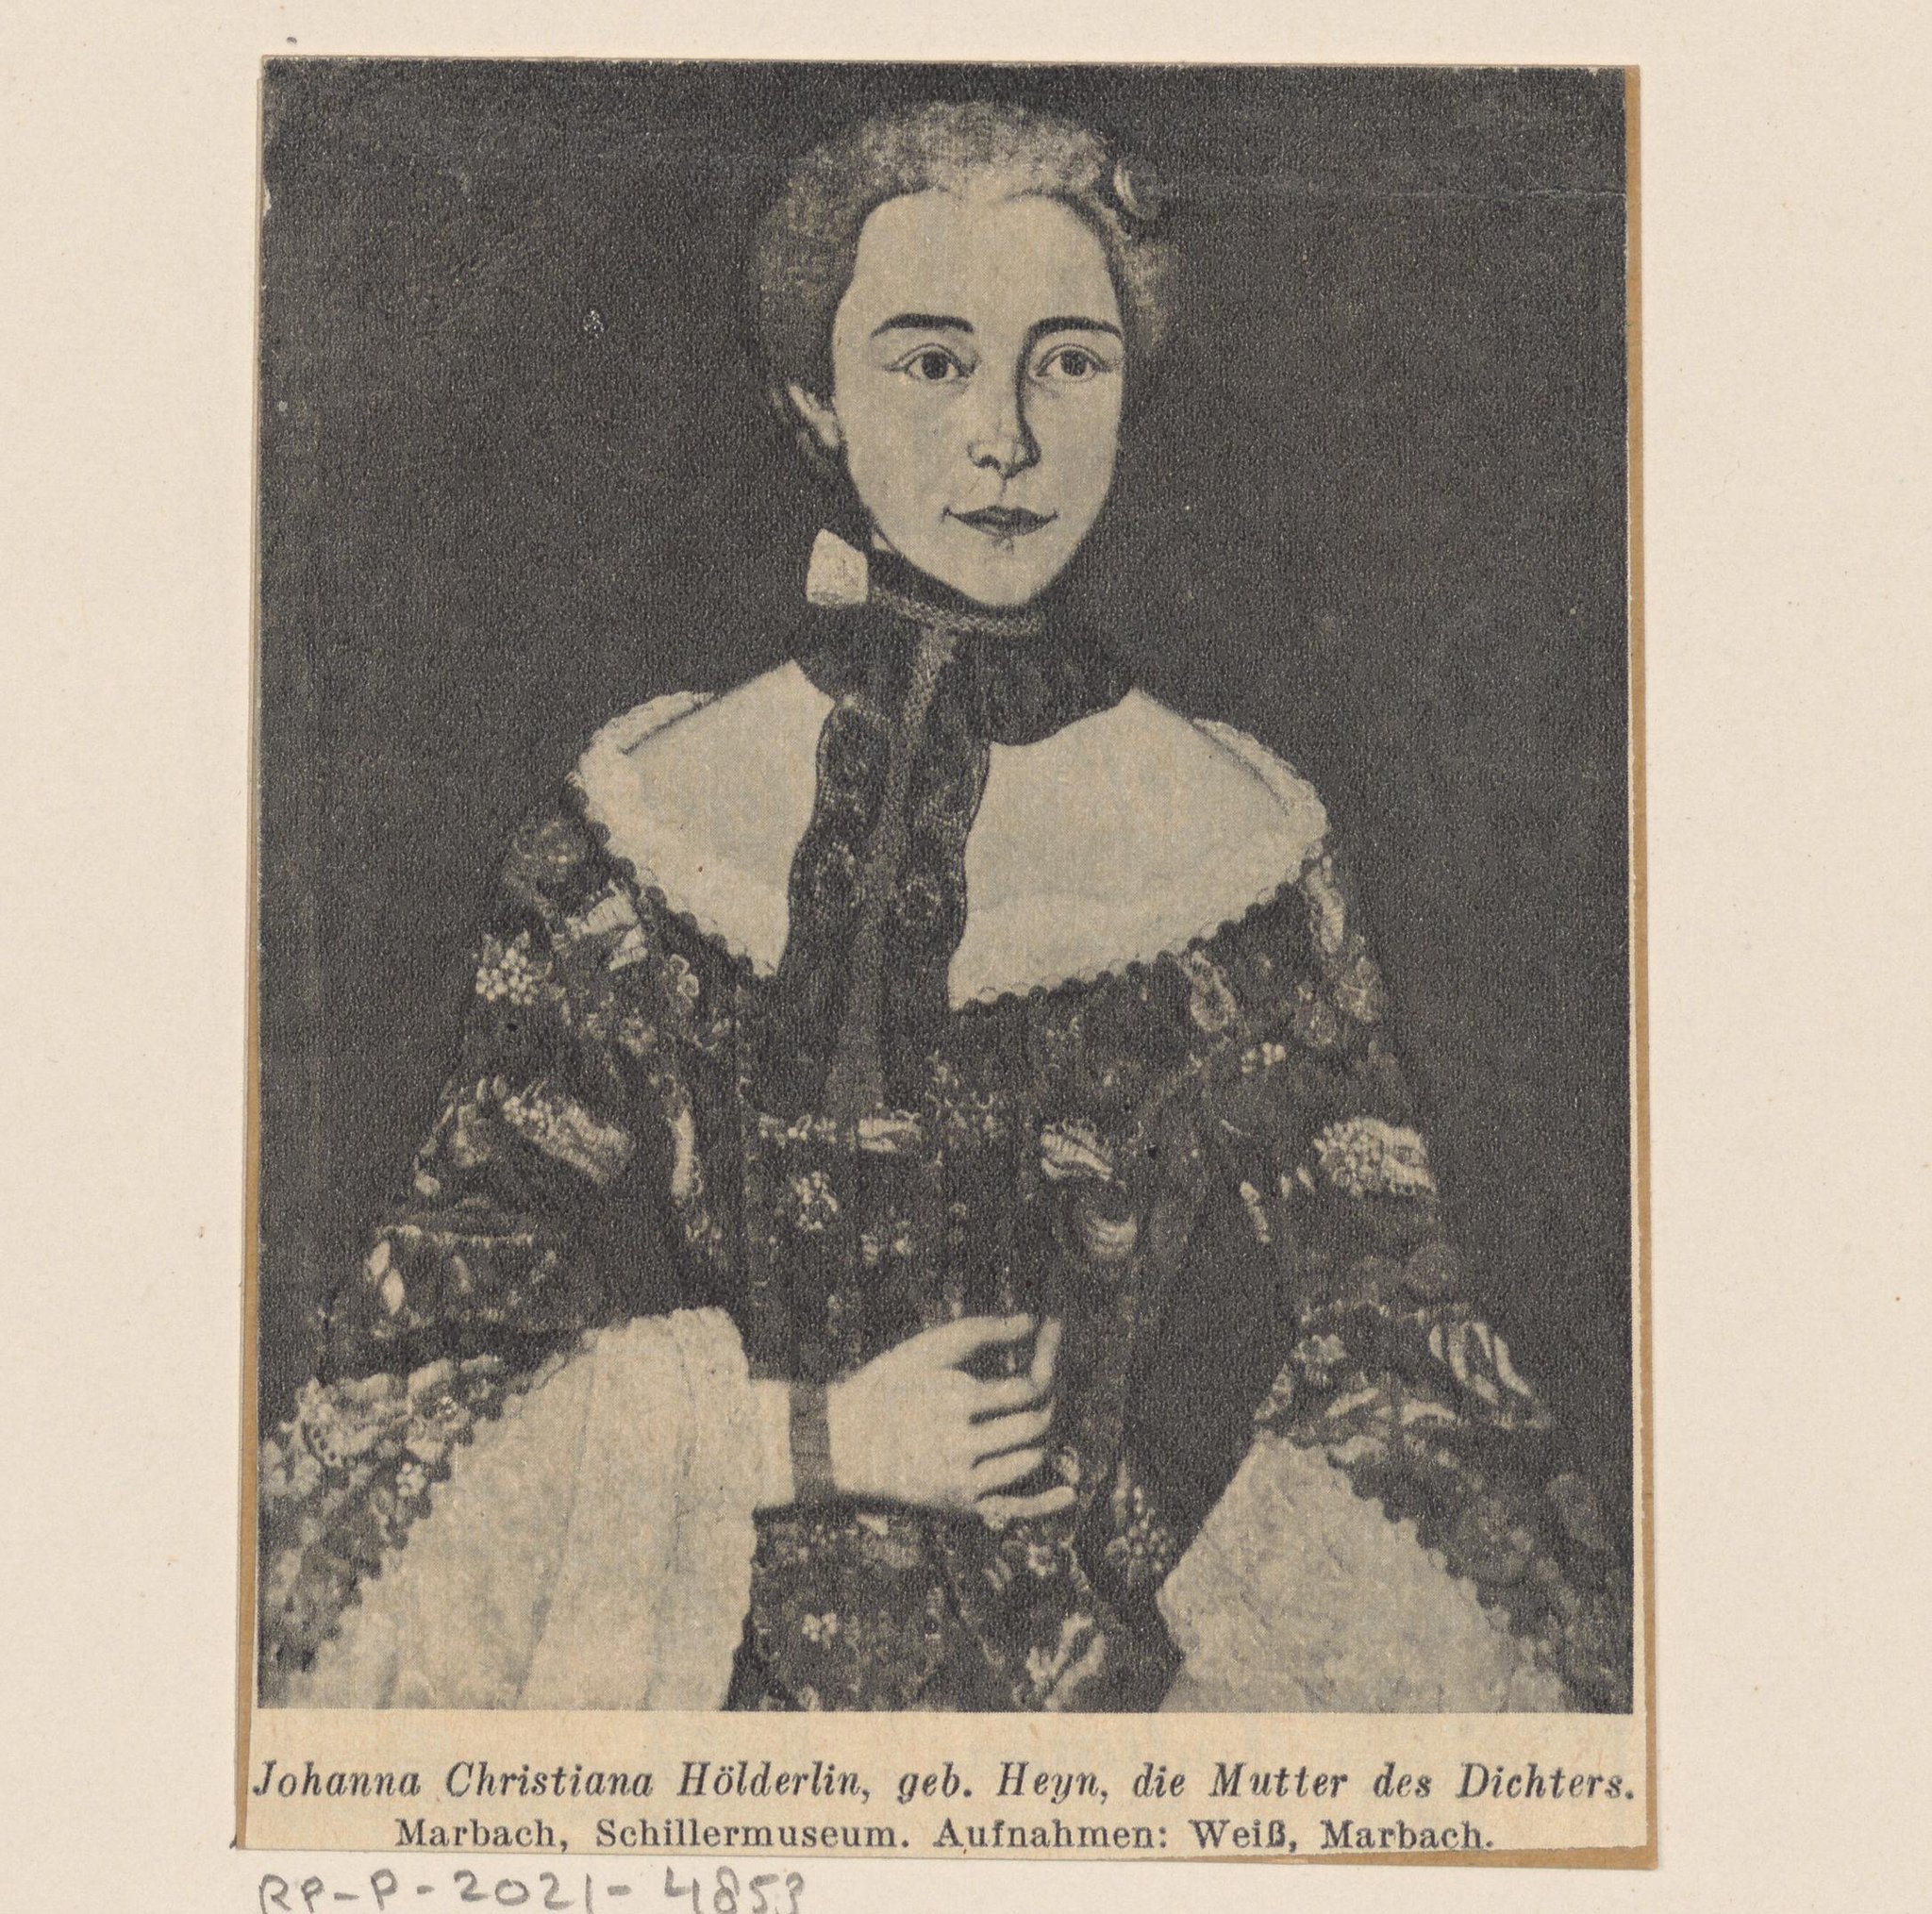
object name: photomechanical print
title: Portret van Johanna Christiana Hölderlin-Heyn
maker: Anonymous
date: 1895-1950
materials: paper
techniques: rotogravure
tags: historical persons - bb - woman